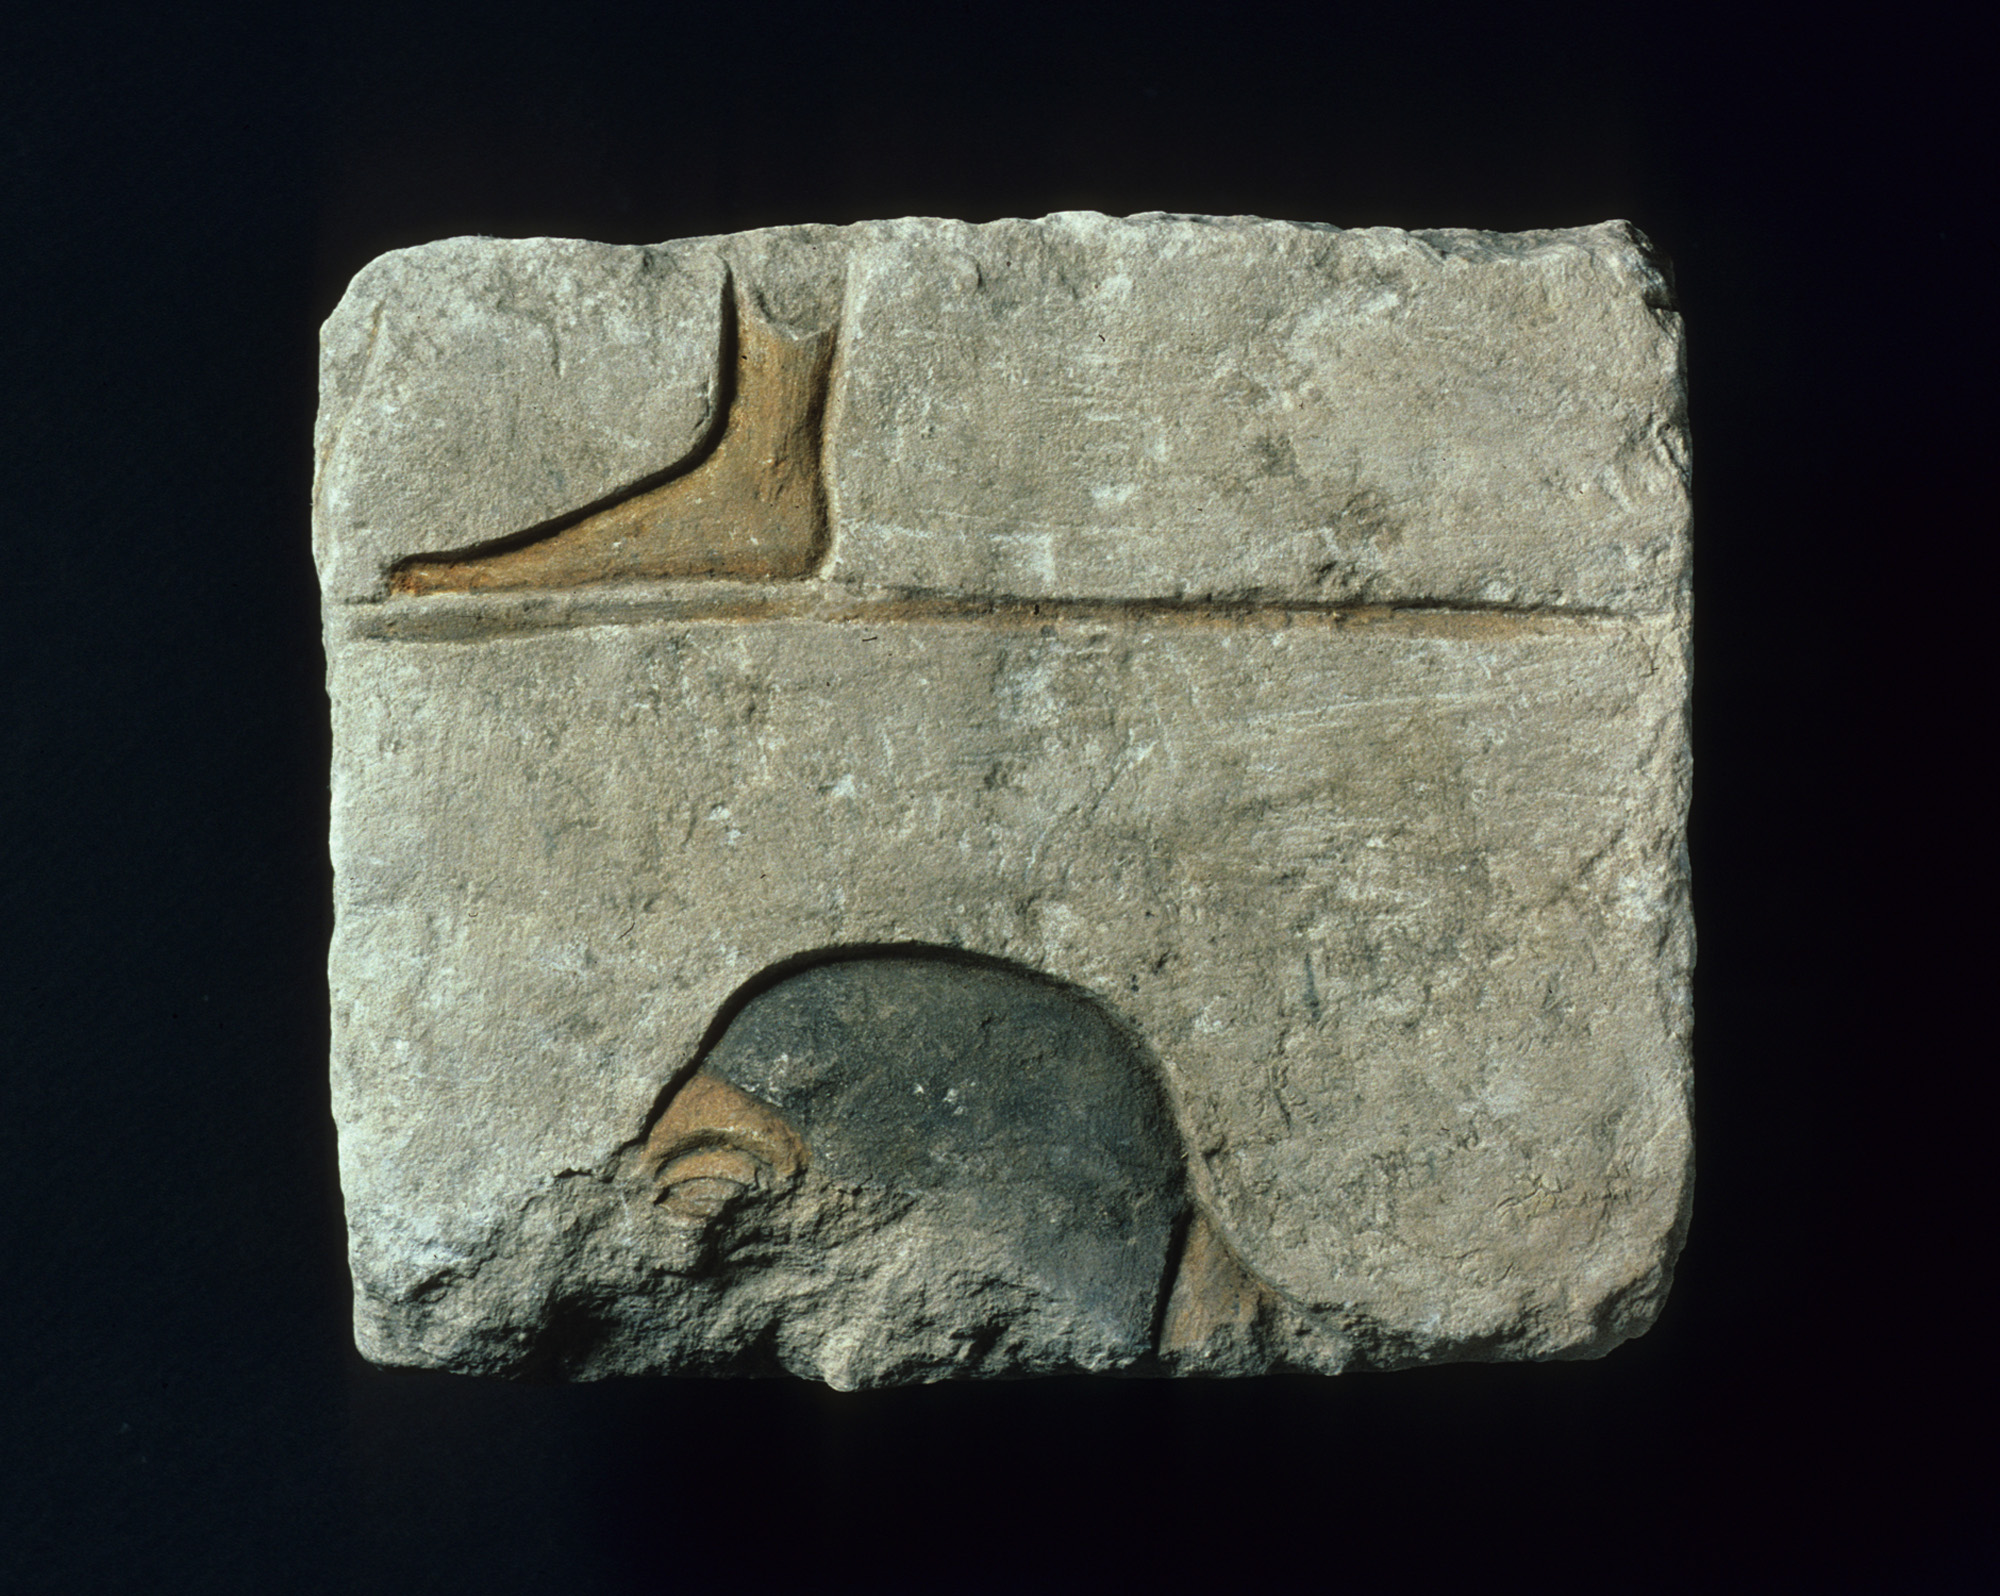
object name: talatat, head and foot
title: Relief with head and foot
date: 1353-1336 BCE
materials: limestone, paint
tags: feet,heads